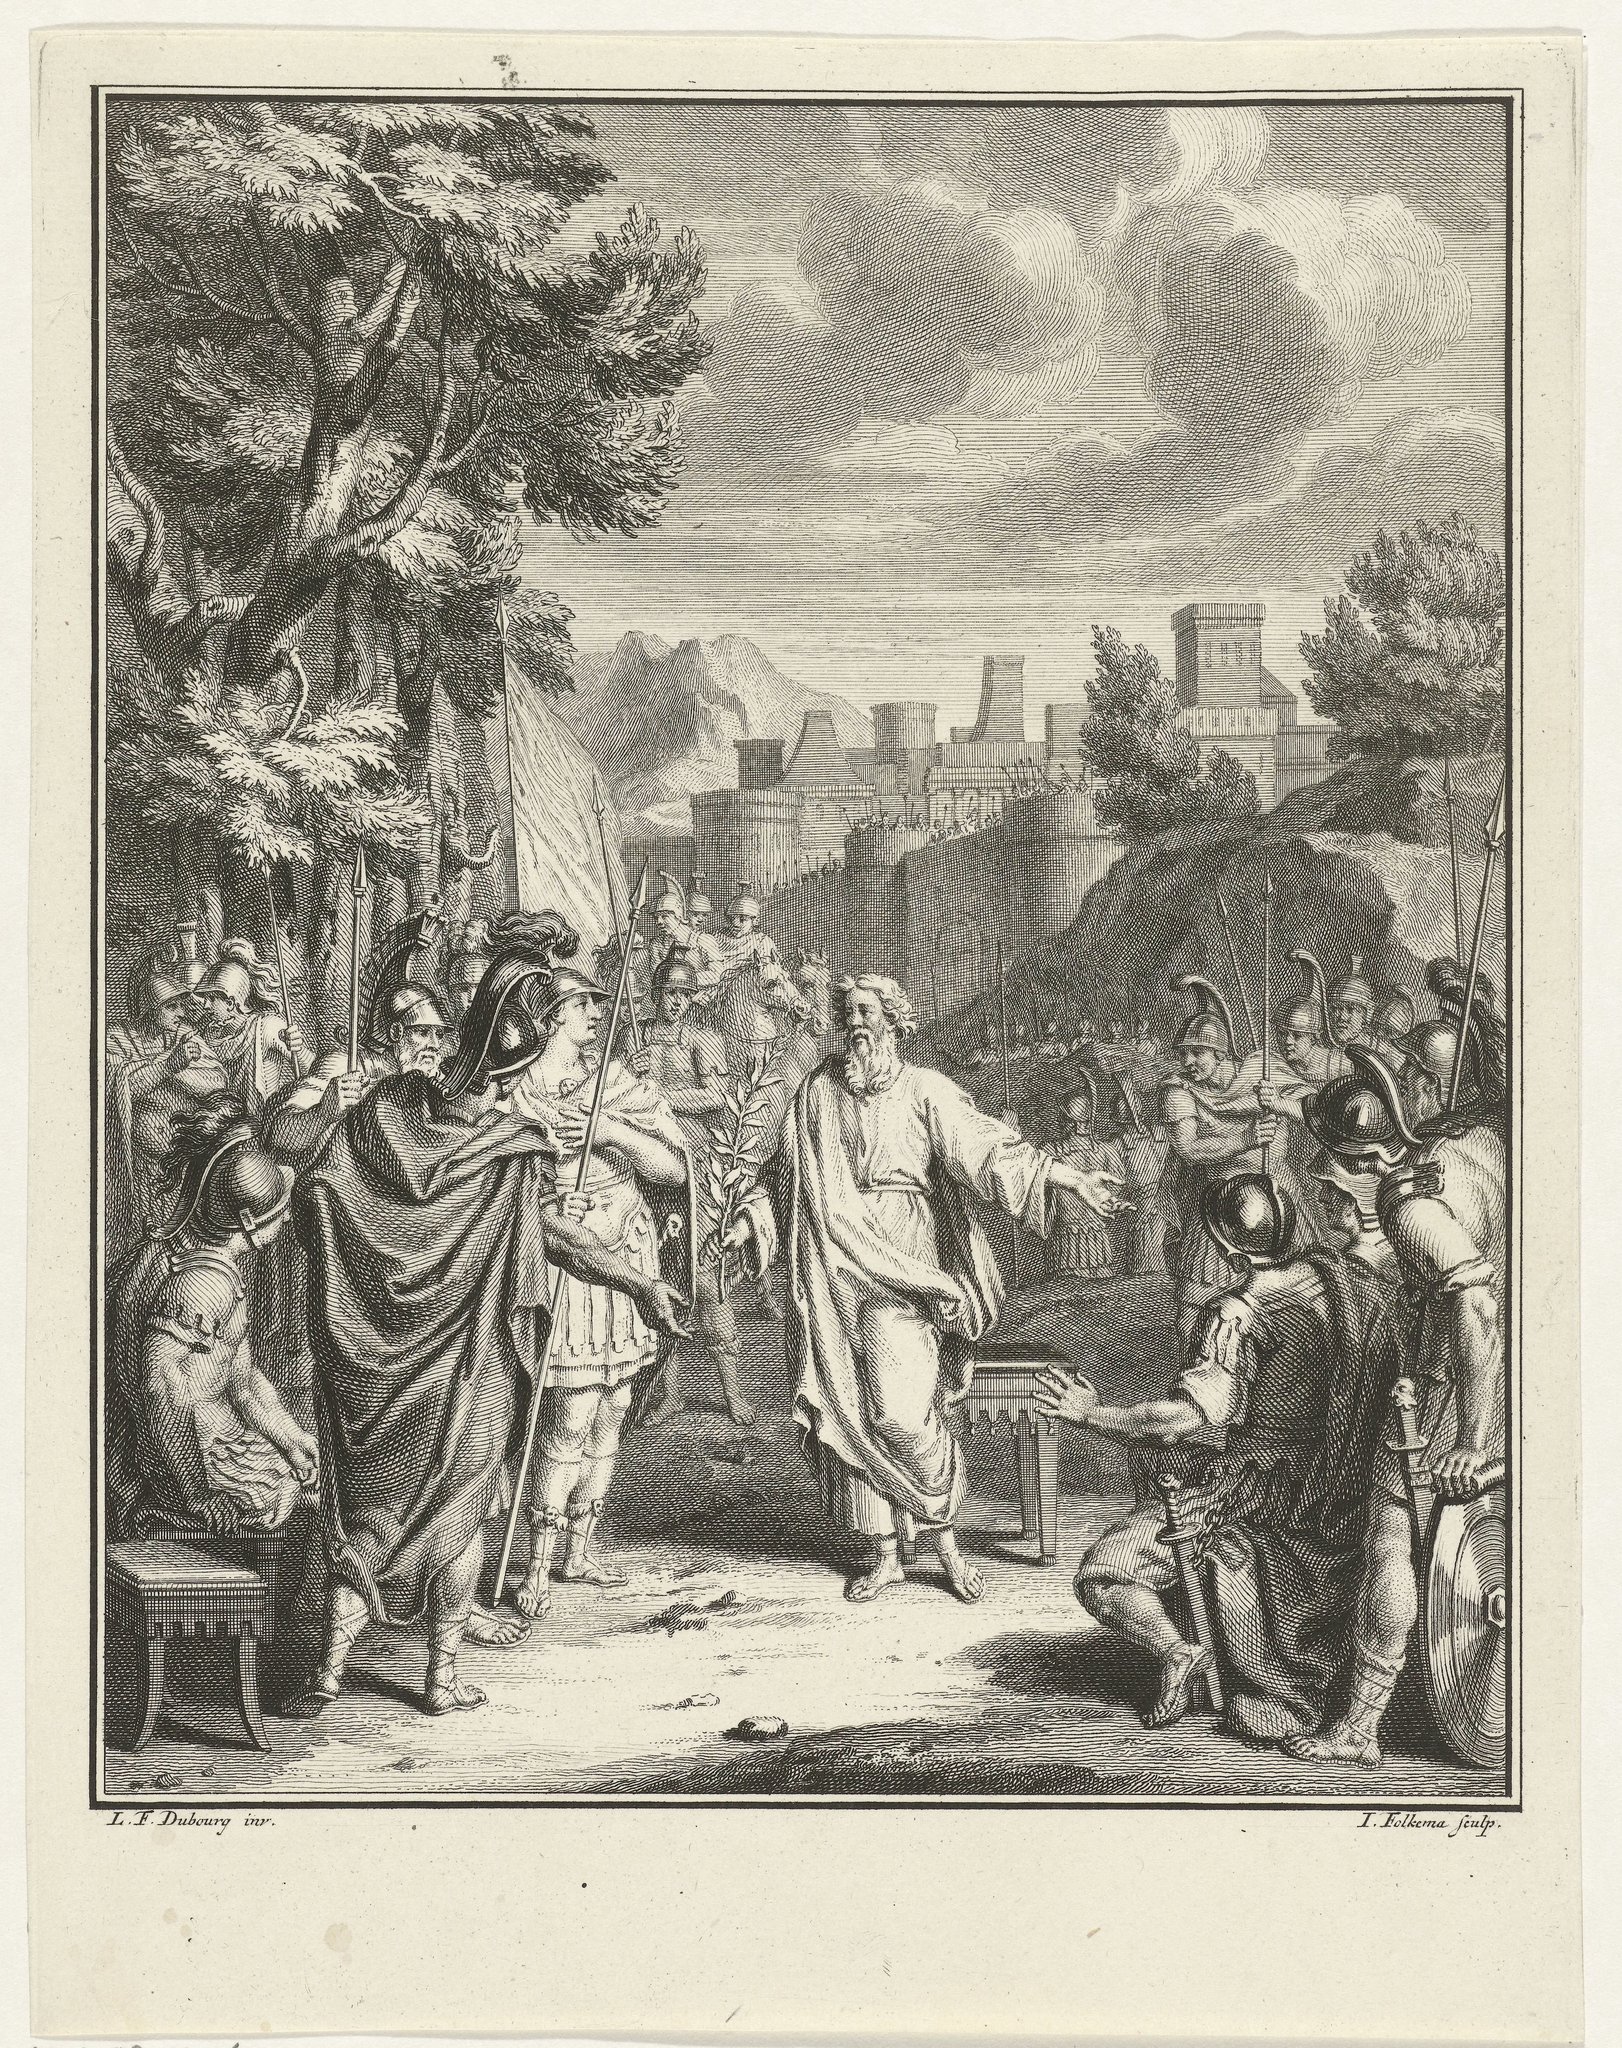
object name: print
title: Mentor biedt Idomeneus een olijftak aan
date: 1703-1767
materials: paper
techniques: etching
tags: (story of) telemachus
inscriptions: collector's mark: Lugt 240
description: Omringd door soldaten biedt de ongewapende Mentor Idomeneus een olijftak aan. Illustratie vervaardigd bij een verhaal uit "Avonturen van Telemachus", geschreven door François de Fénélon.